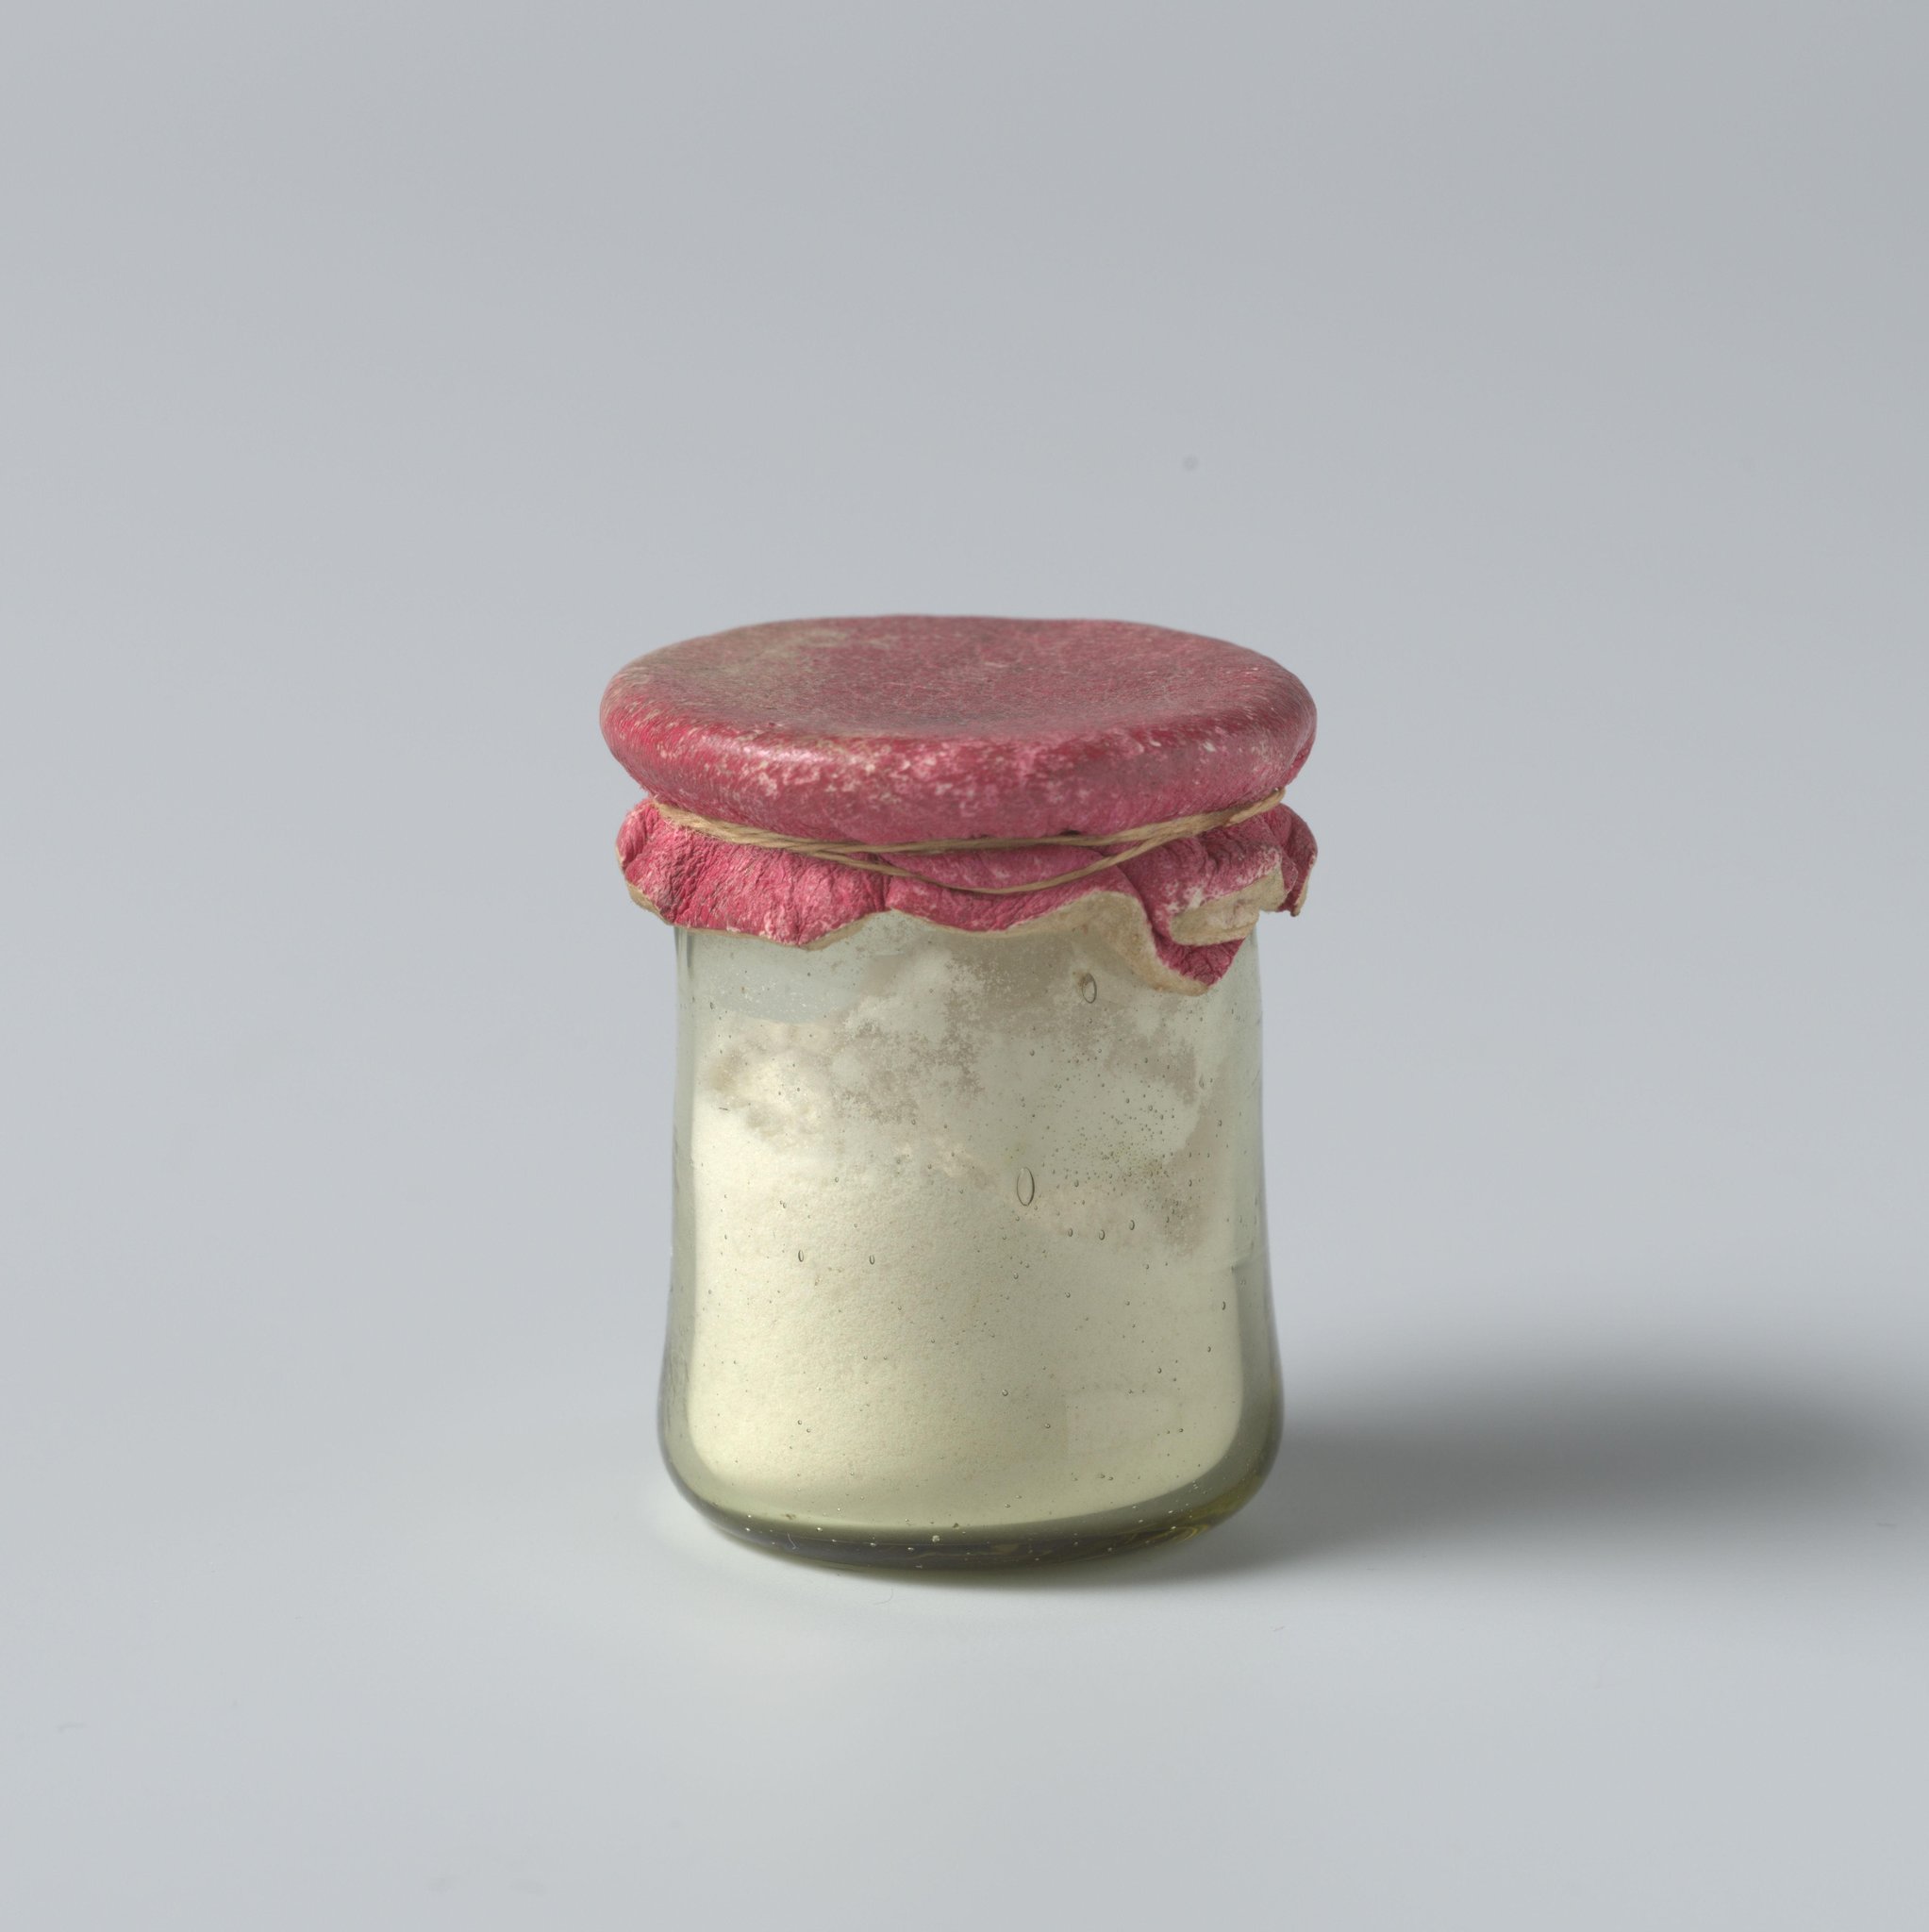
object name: storage jar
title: Voorraadpot, cilindervormig, met ingestoken ziel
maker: Anonymous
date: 1700-1799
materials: glass, leather, fiber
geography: netherlands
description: Voorraadpot van helder groen glas, cilindervormig, met enigszins ingestoken ziel, en wijde halsrand en insnoering. Afgesloten door middel van een stuk roze leer, omwonden door touw. De pot is gevuld met een wit poeder.